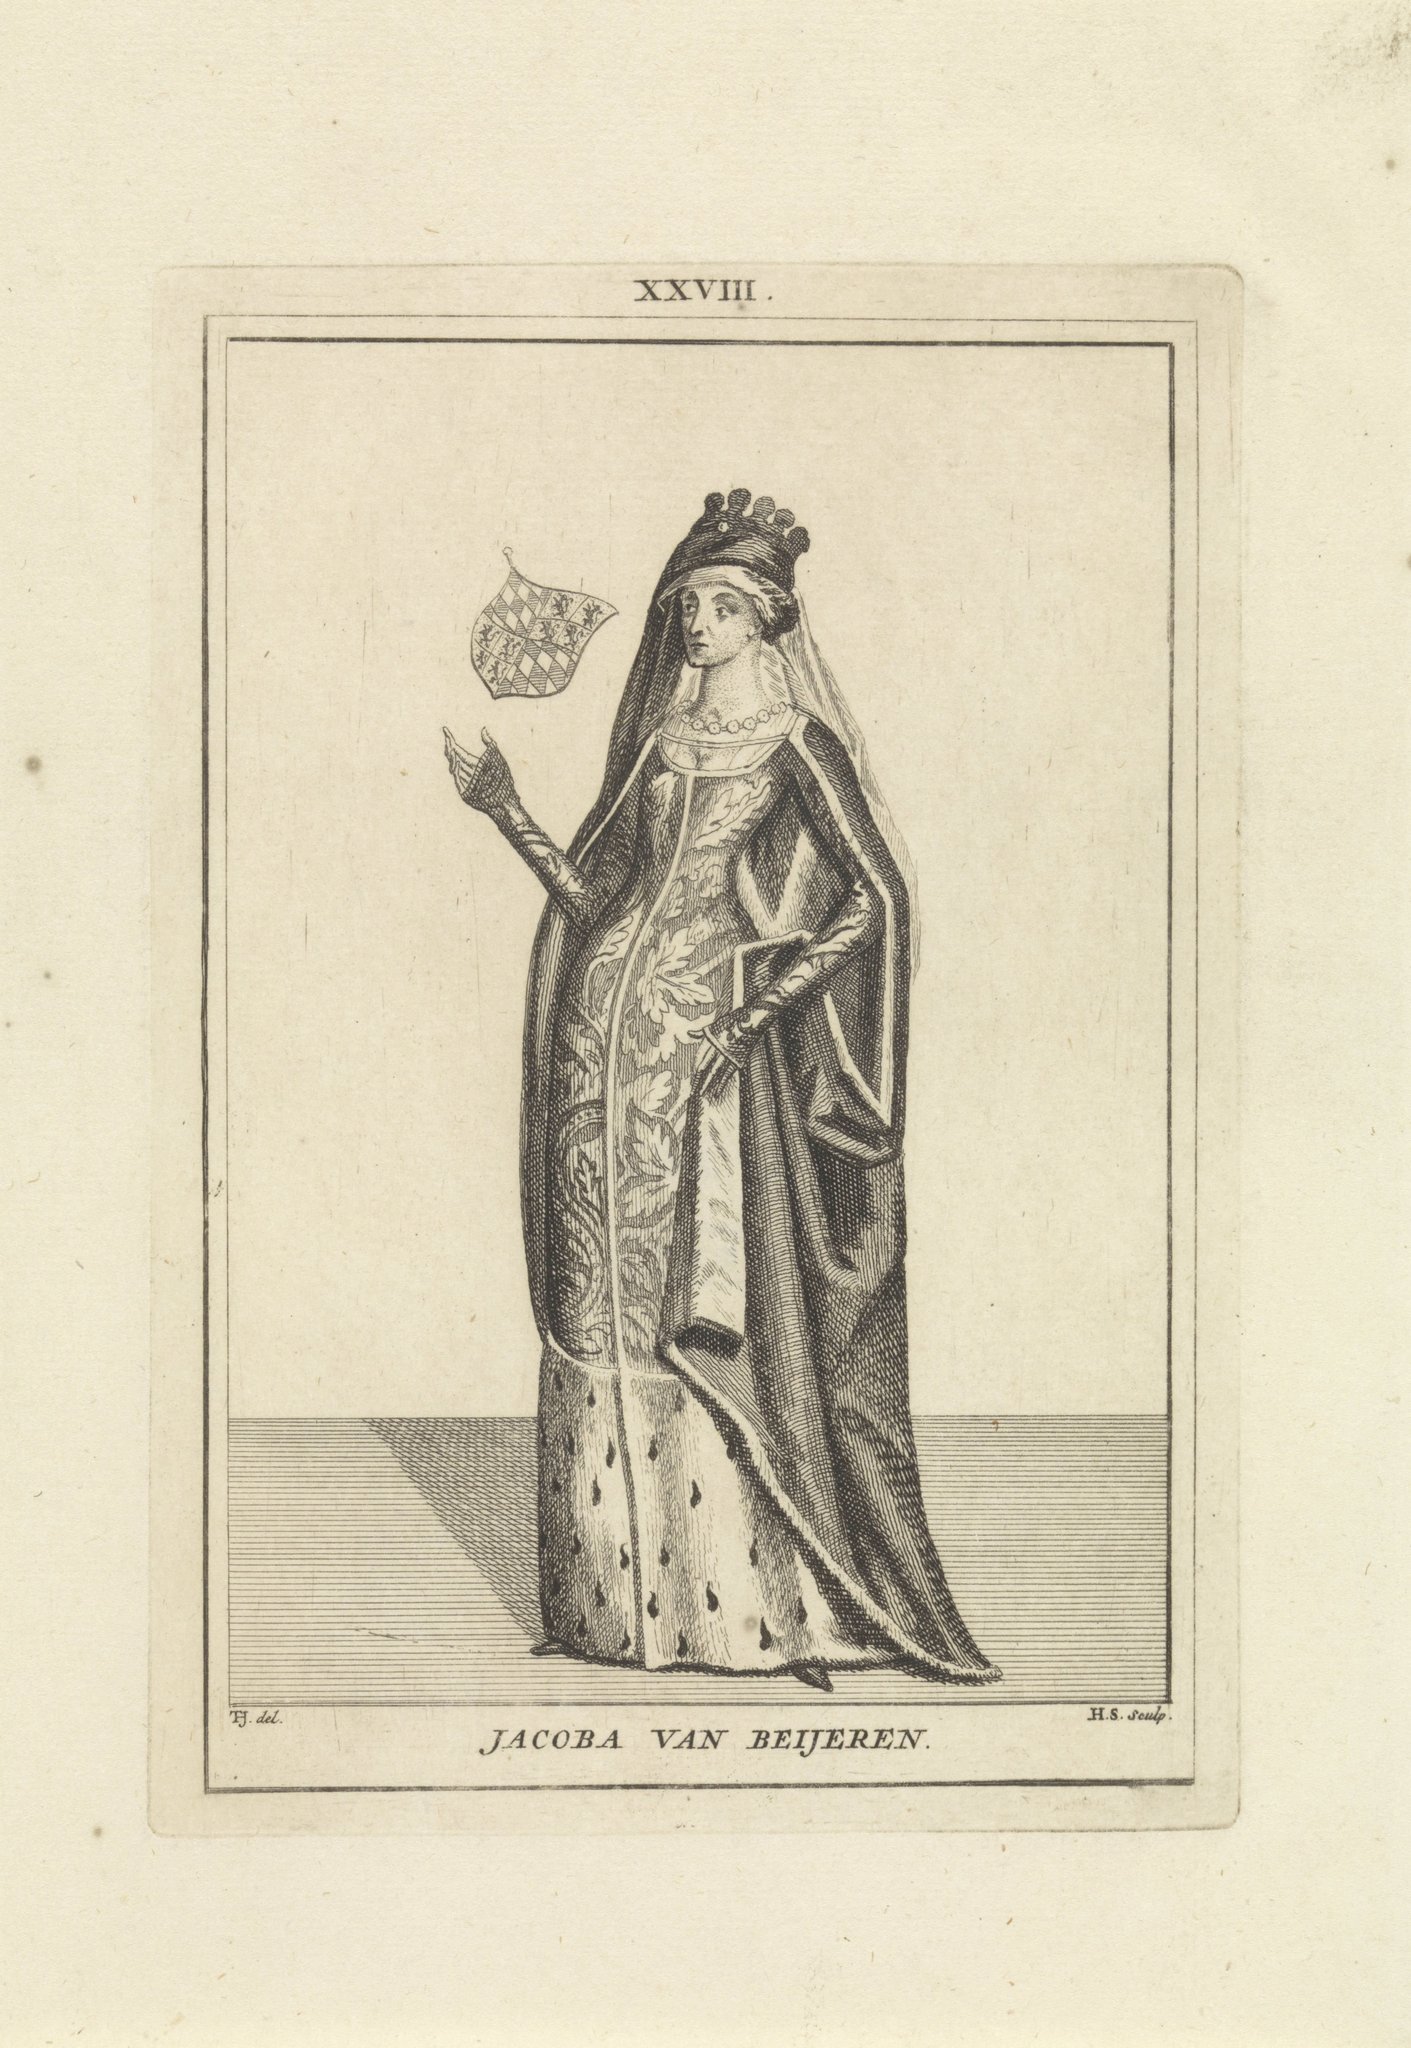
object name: print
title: Portret van Jacoba van Beieren, gravin van Holland, Zeeland en Henegouwen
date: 1745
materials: paper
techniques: etching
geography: haarlem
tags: jacoba of bavaria (countess of hainaut), nobility and patriciate; chivalry, knighthood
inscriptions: collector's mark: Lugt 2228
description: Boekillustratie voor: Langendyk, Pieter. De Graaven van Holland, in jaardichten beschreven door Pieter Langendyk. Verykt met alle de beeldtenissen dier prinsen, naauwkeurig getekend naar de echte aloude tafereelen of de zaal van't raadhuis der stad Haarlem. Haarlem: J. Bosch, 1745.